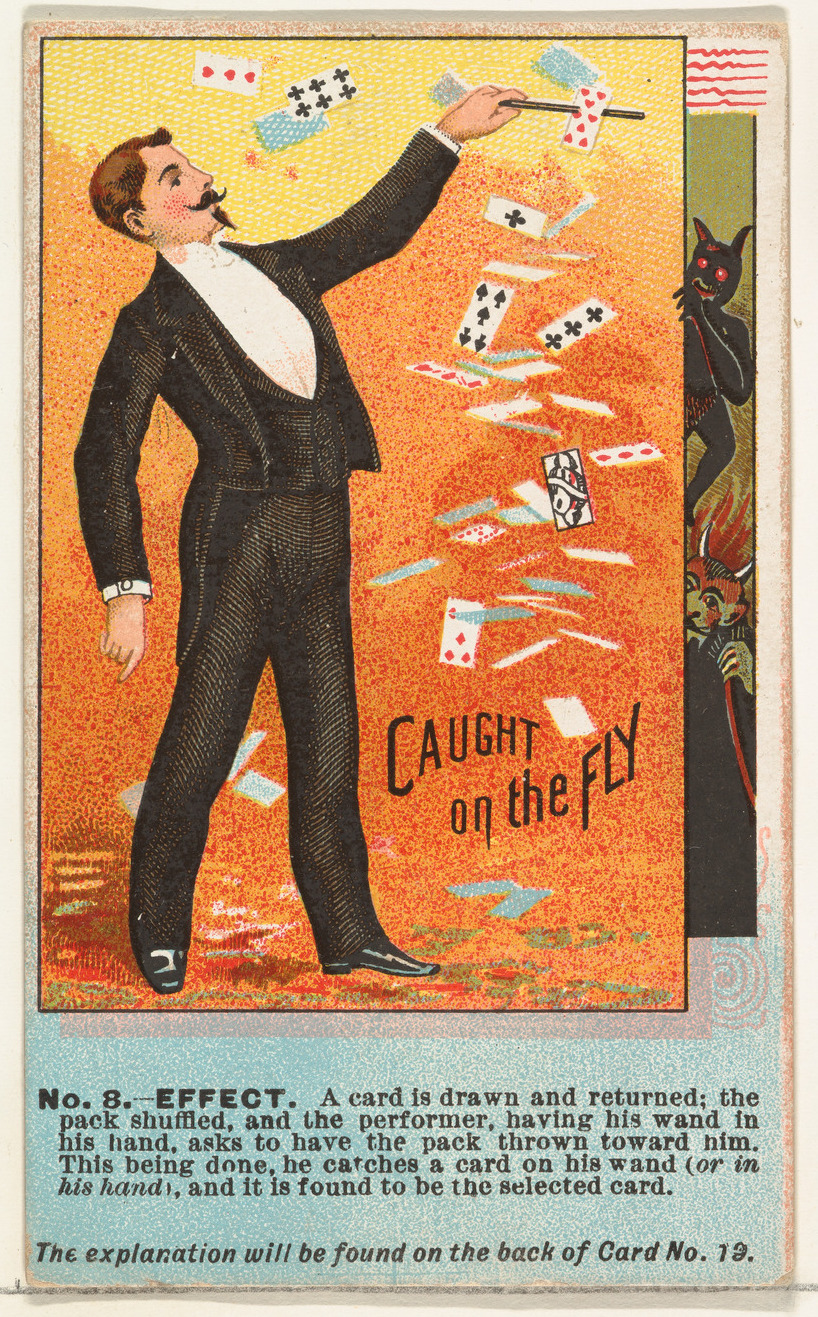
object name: print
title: Number 8, Caught on the Fly, from the Tricks with Cards series (N138) issued by W. Duke, Sons & Co. to promote Honest Long Cut Tobacco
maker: w. duke, sons & co.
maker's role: publisher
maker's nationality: american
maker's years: 1870-1920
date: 1887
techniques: color lithograph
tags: men,magic,playing cards